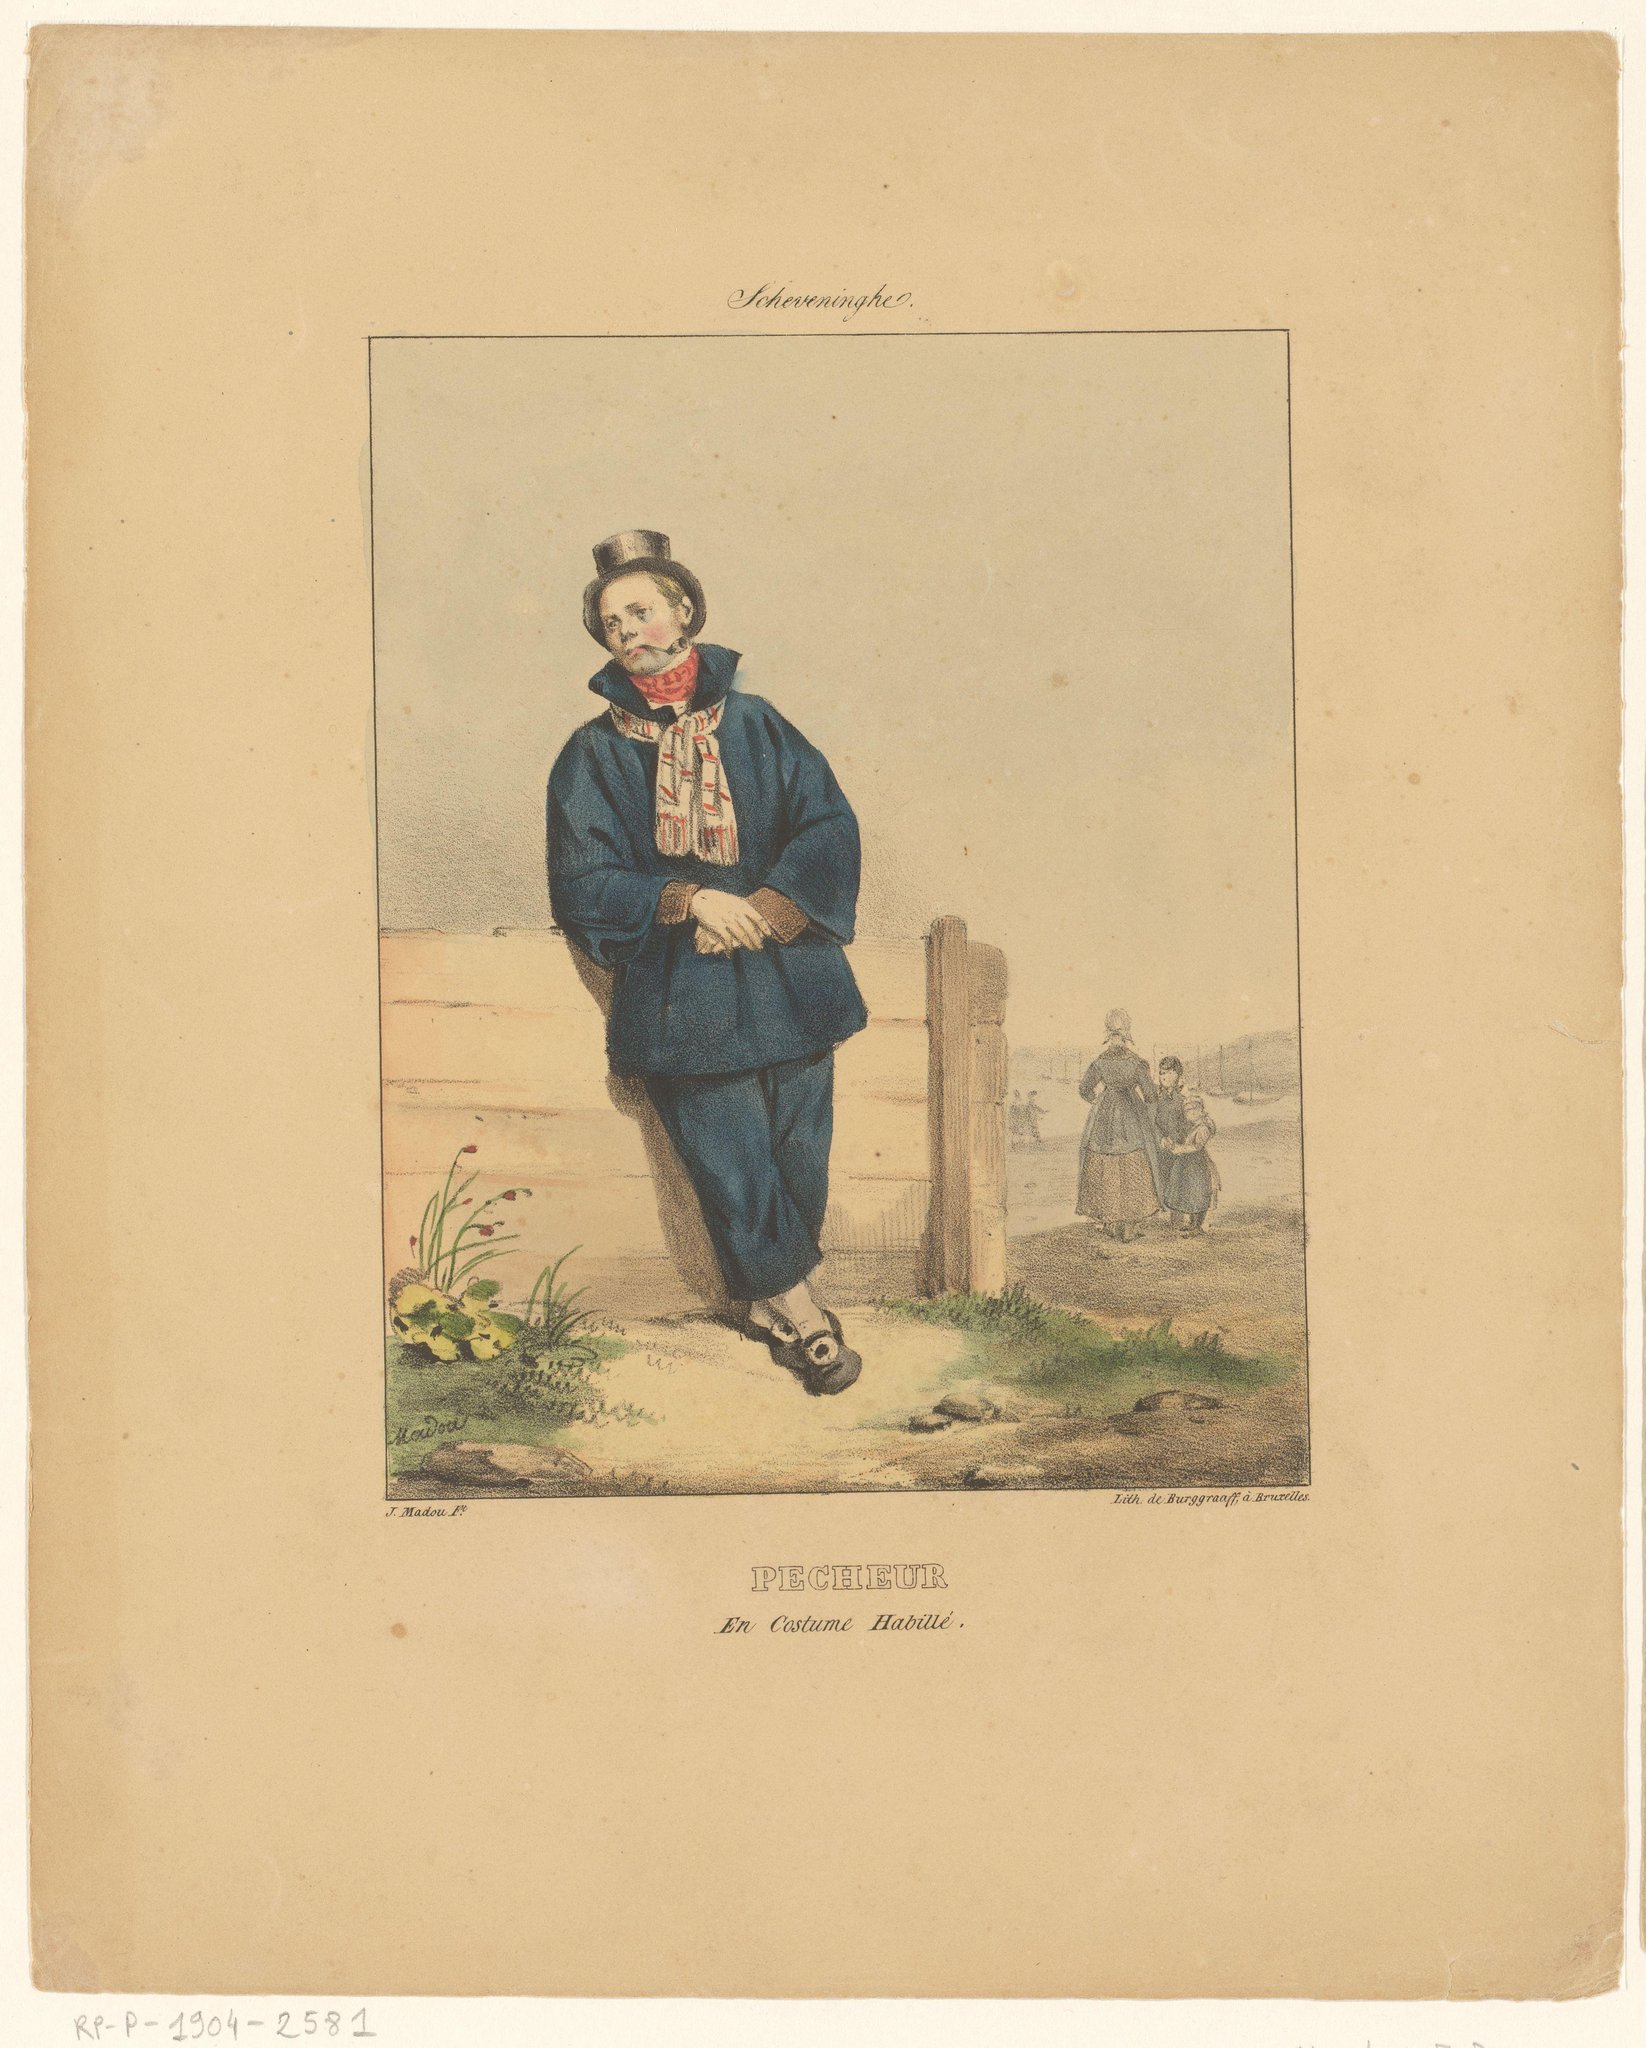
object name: print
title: Kostuums van de inwoners van Nederland en België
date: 1825-1835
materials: paper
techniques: hand coloring, lithograph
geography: brussels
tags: pipe ~ tobacco, folk costume, regional costume, fisherman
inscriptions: collector's mark: Lugt 2228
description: Van den Burggraaff wilde een serie (twintig afleveringen met telkens vier platen) uitgeven met kostuums uit alle provincies van Nederland en België onder de titel 'Costumes du peuple de toutes les provinces des Pays-Bas'. Hij begint met deze serie in 1825 en eindigt hiermee bij de dertiende aflevering in 1830. Omdat in 1830 België zicht afsplitst van Nederland geeft hij de prenten daarna apart uit onder de titels 'Costumes de peuple Hollandais' en 'Collection de costumes du peuple des provinces de la Belgique' (1835).